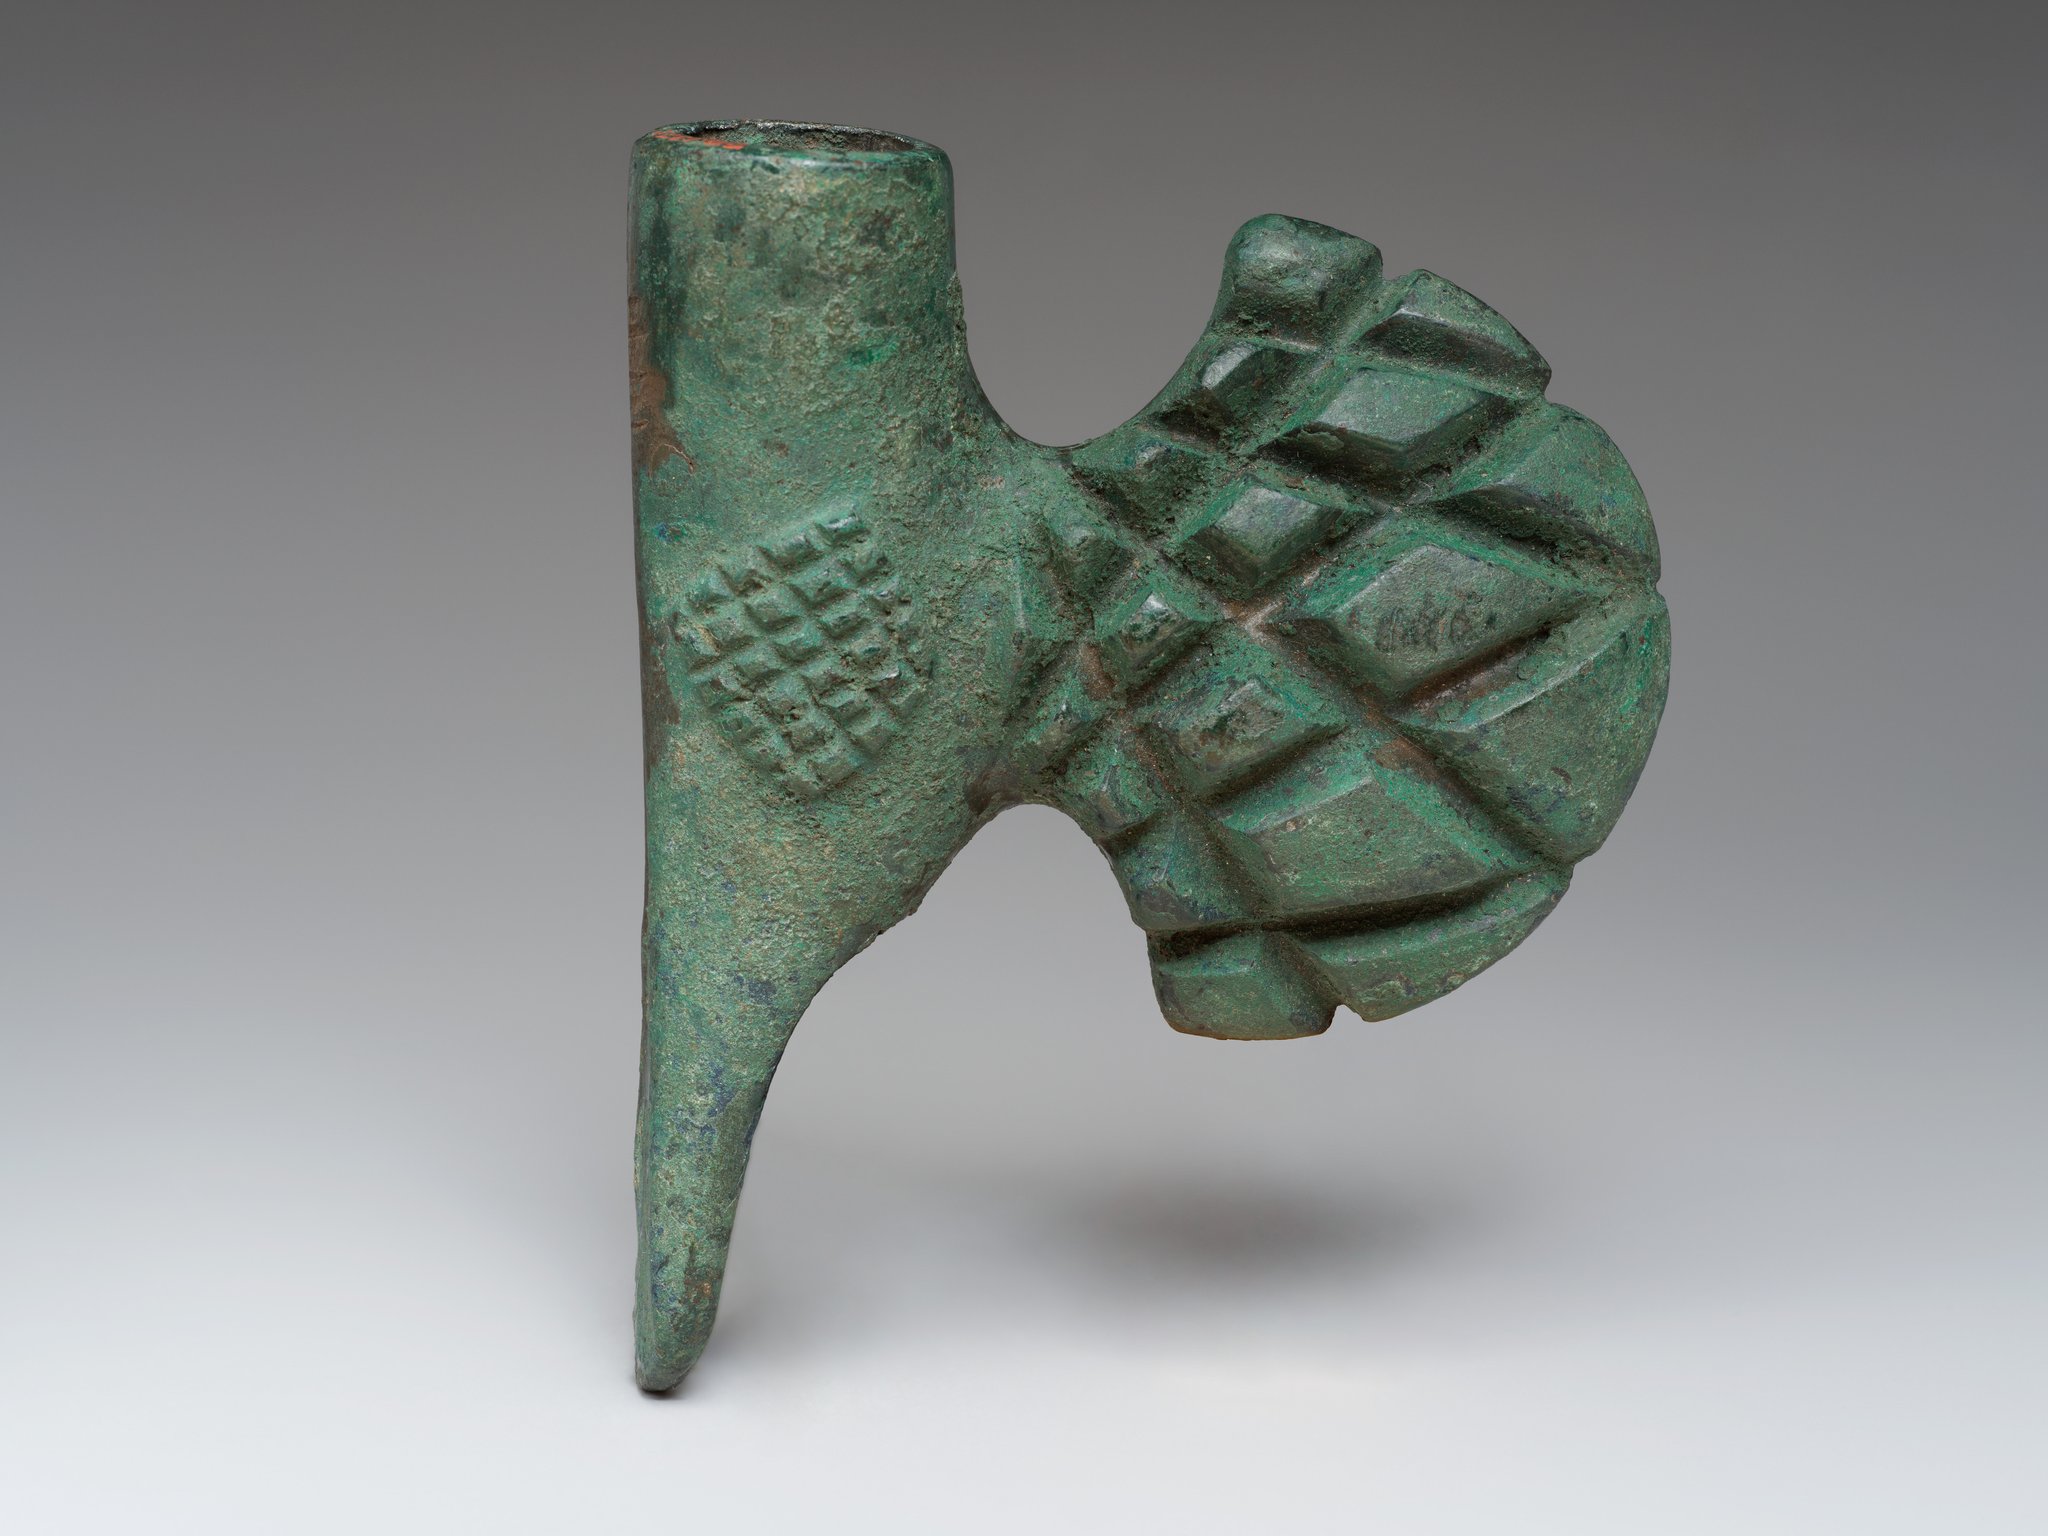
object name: axe or mace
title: Axe or mace head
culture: hattian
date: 2300-2000 BCE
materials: bronze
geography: central anatolia